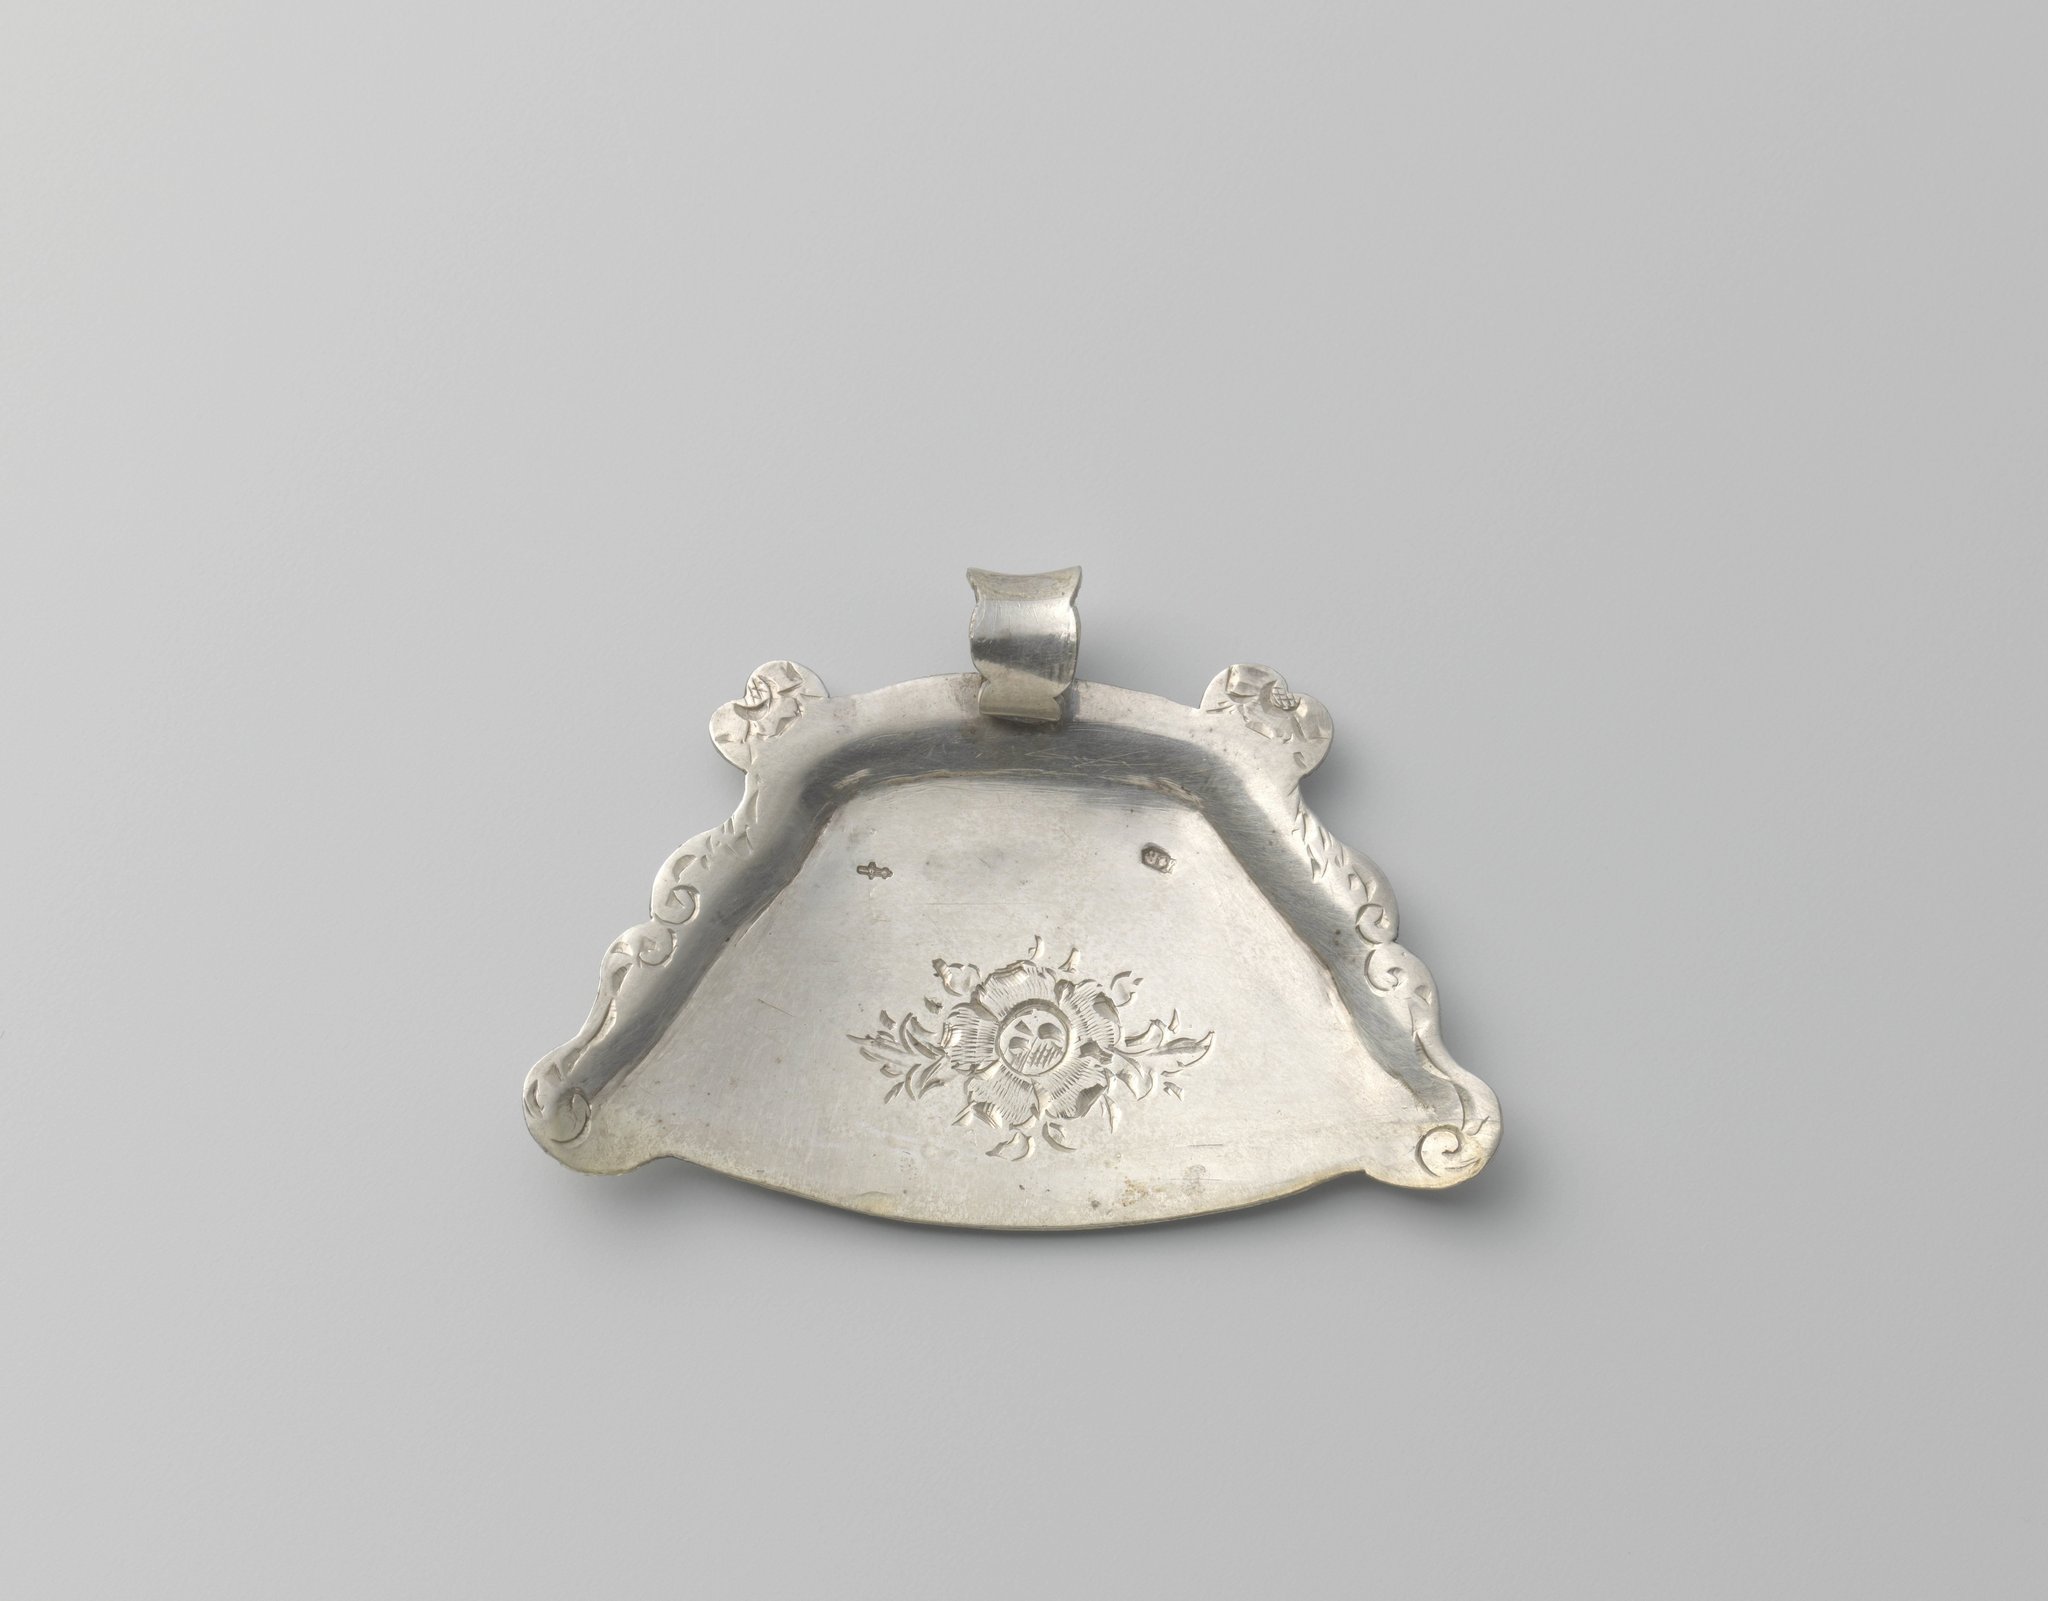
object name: miniature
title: Kruimelblik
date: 1819-1822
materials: silver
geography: amsterdam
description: Kruimelblik met plat, rond handvat. De randen van het blik zijn bewerkt (accolade-vorm) en gegraveerd. In het midden van het blik zijn bloemen gegraveerd. Bij het blik hoort een tafelschuier met invnr. BK-NM-11177-108-b. Het blik is gemerkt: een zwaard en een merk van de Firma Beversen & Rodenberg.